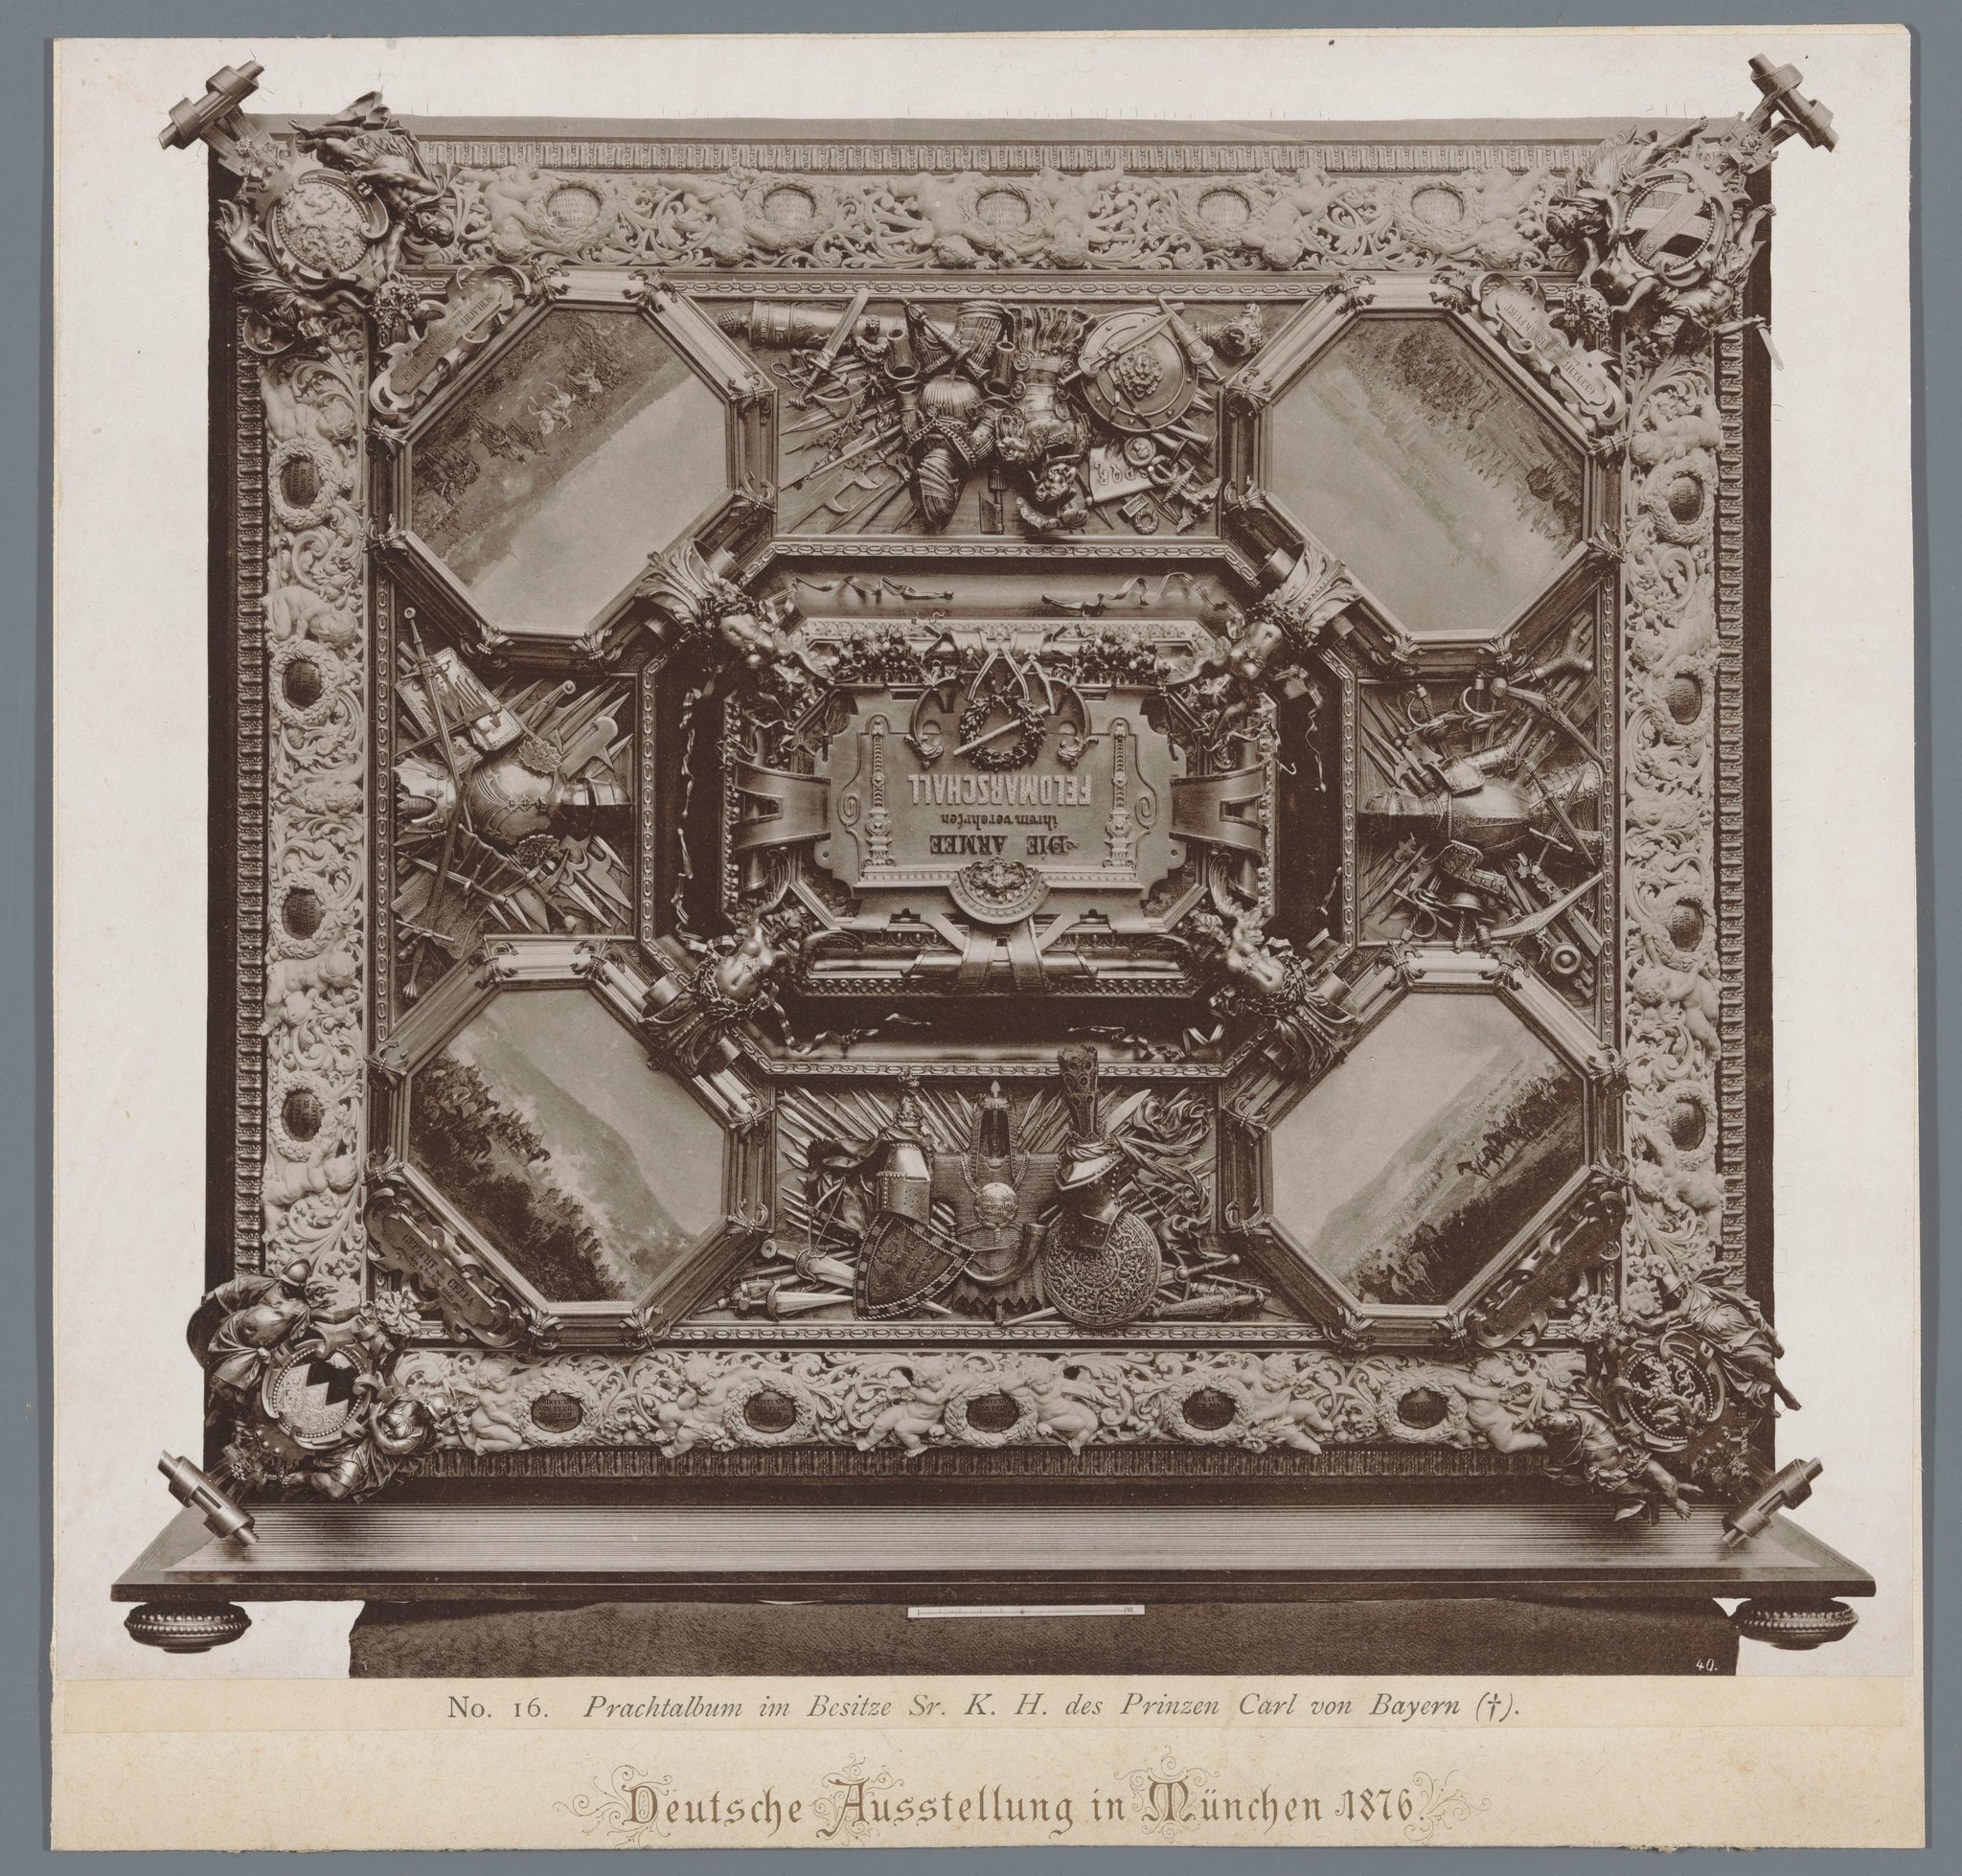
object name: photograph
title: Opstelling van een prachtalbum in het Bayerisches Nationalmuseum te München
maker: Anonymous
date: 1876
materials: cardboard, paper, ink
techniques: photograph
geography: bayerisches nationalmuseum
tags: book in which illustrations are essential, temporary exhibition, 'salon'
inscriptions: inscription: ‘Deutsche Ausstellung in München 1876.’, number: ‘40.’